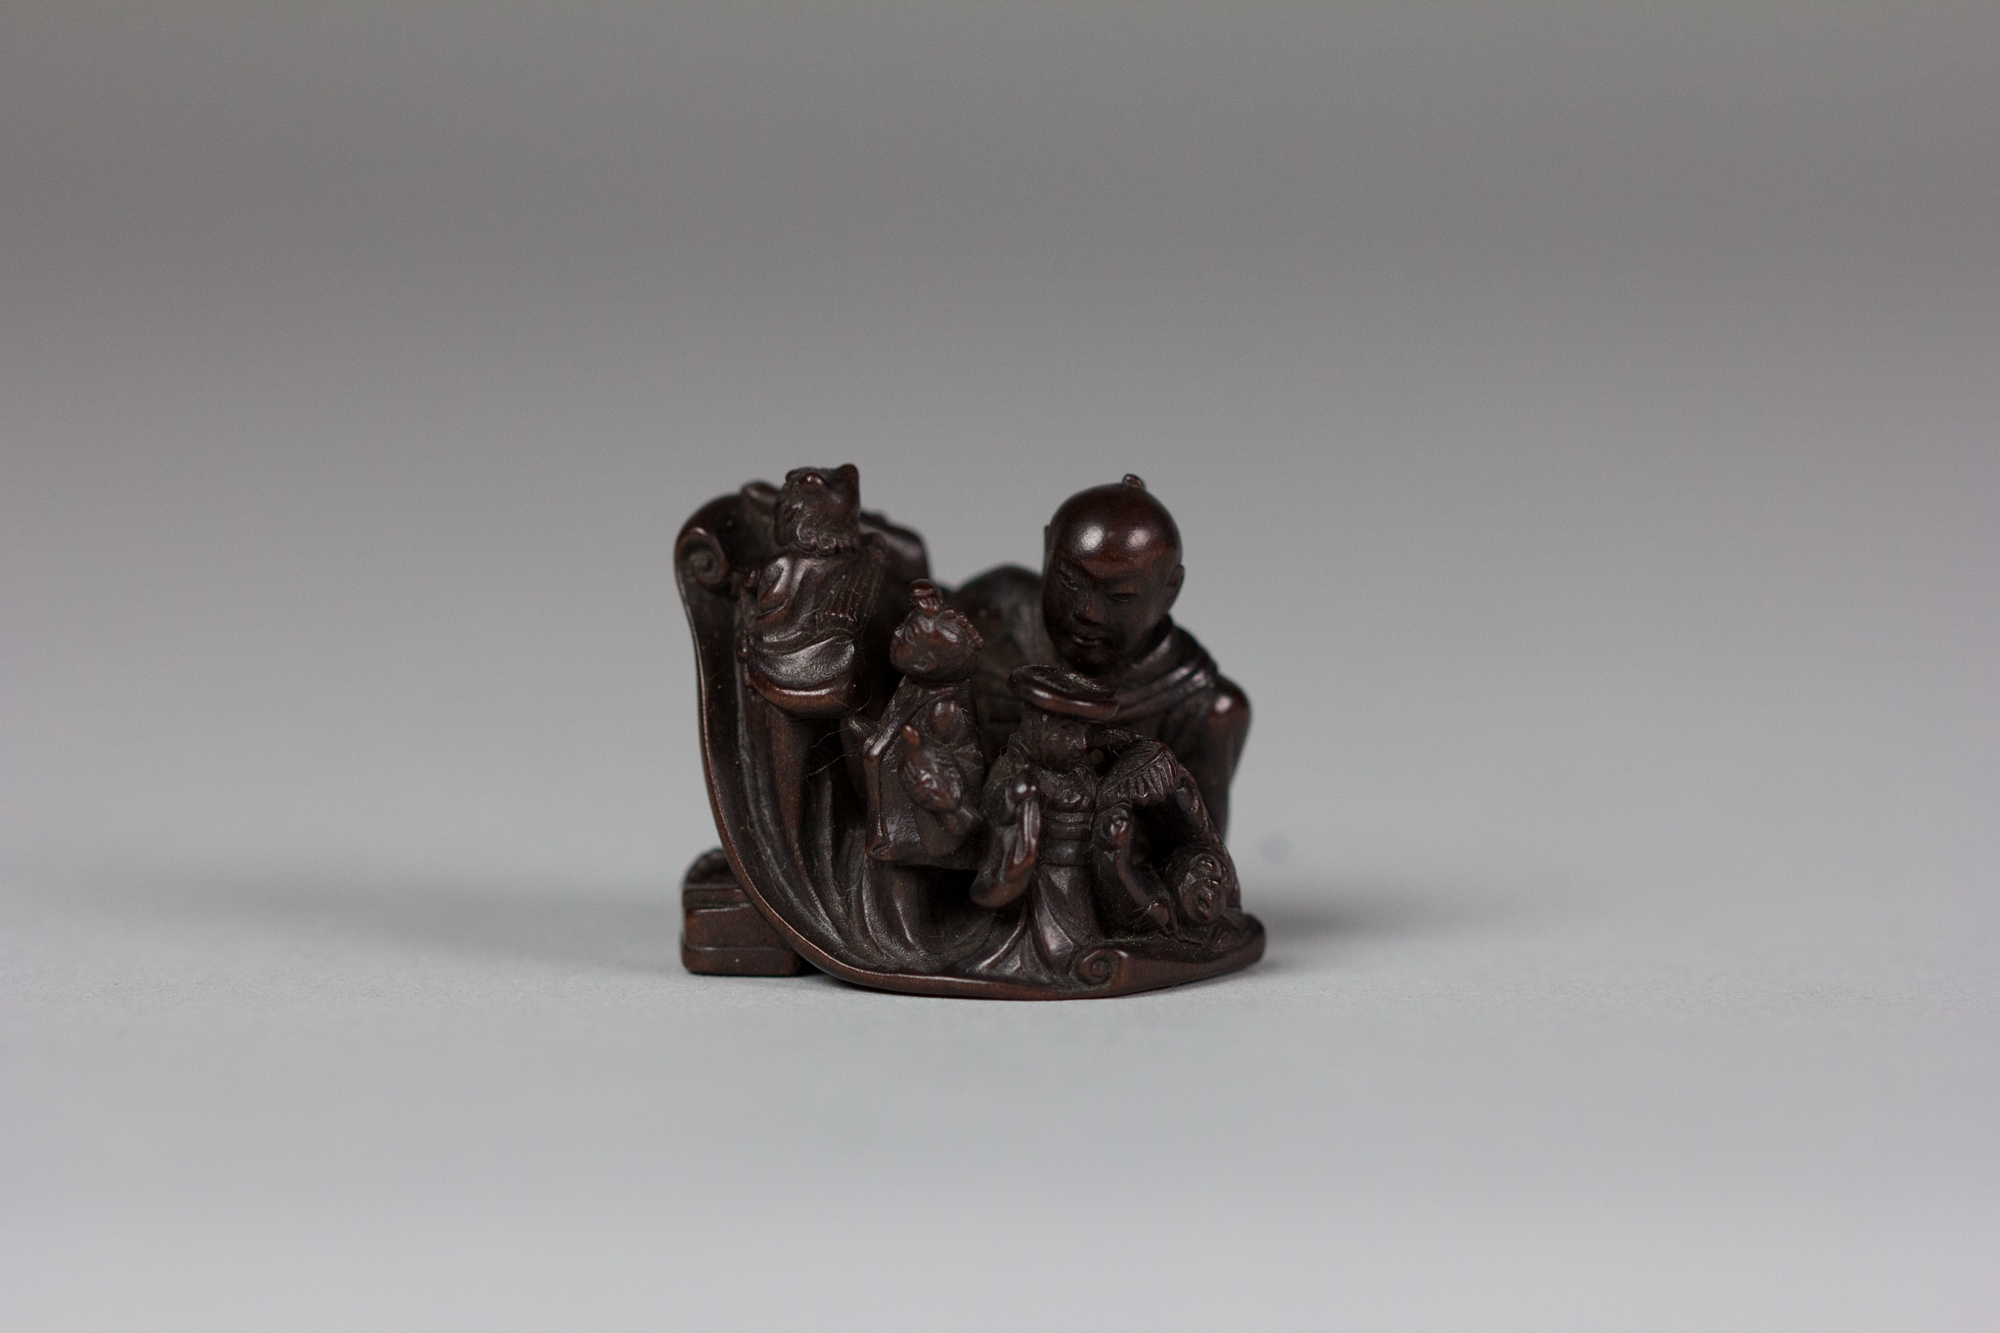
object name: netsuke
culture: japanese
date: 1701-1800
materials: wood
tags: men